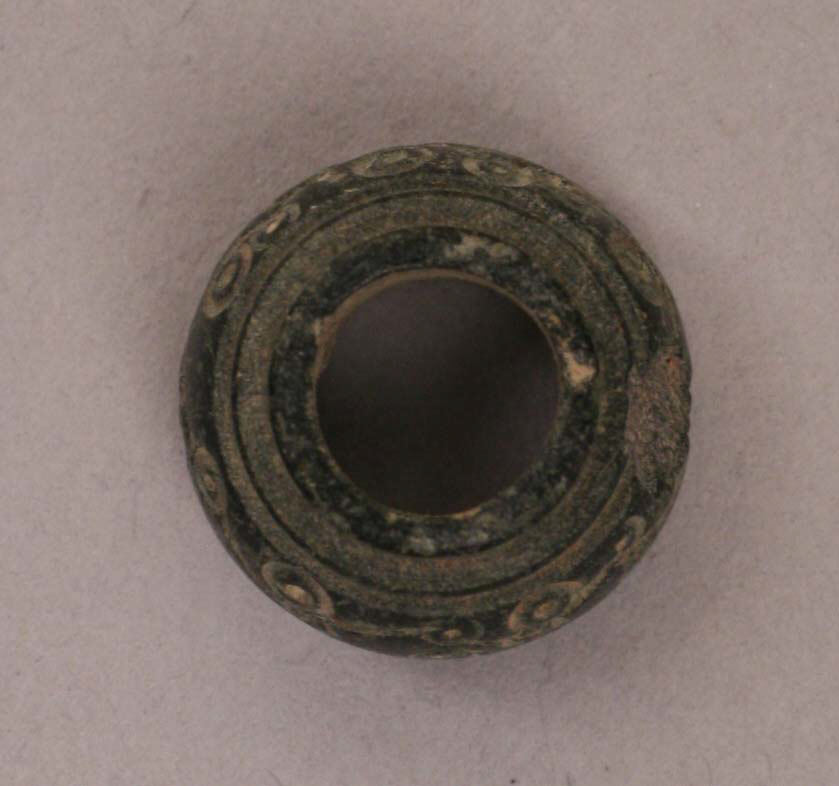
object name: button or bead or spindle whorl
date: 701-1000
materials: stone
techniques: incising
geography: iran